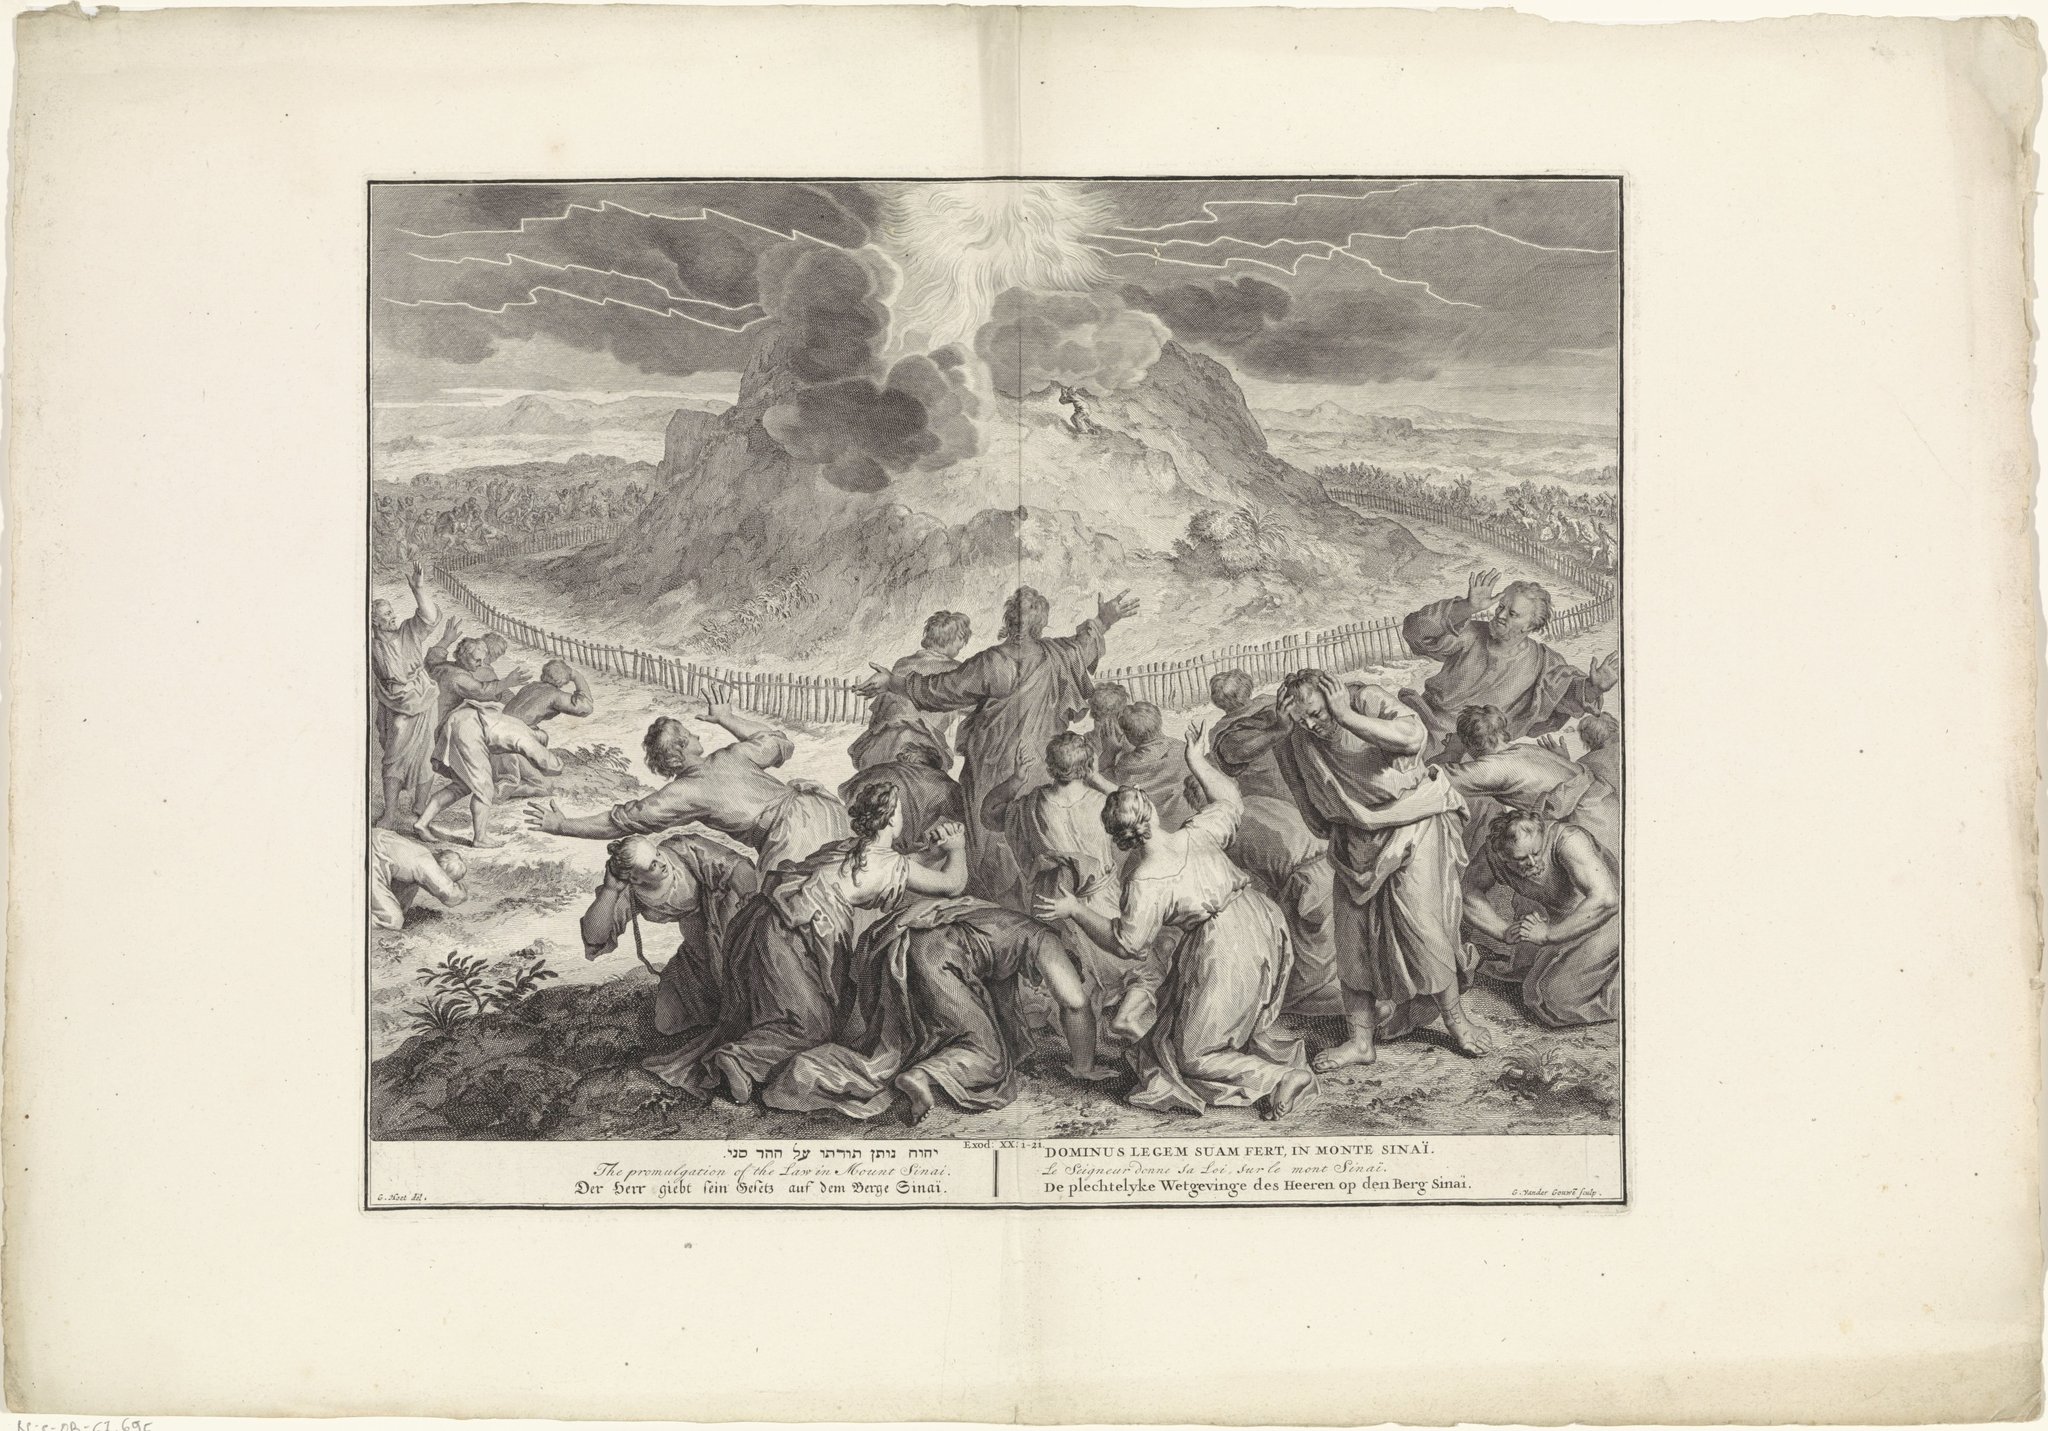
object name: book illustration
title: Mozes op de berg Sinaï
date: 1728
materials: paper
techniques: engraving, etching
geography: the hague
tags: mount sinai is covered by a thick cloud, thunder and lightning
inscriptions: collector's mark: Lugt 2228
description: Mozes spreekt met God op de berg Sinaï. Het Joodse volk op de voorgrond raakt in paniek bij het horen van donderslagen en het zien van lichtflitsen en van rook die uit de berg komt (Ex. 20:21). De prent heeft een Hebreeuws, Latijns, Frans, Engels, Duits en Nederlands onderschrift.